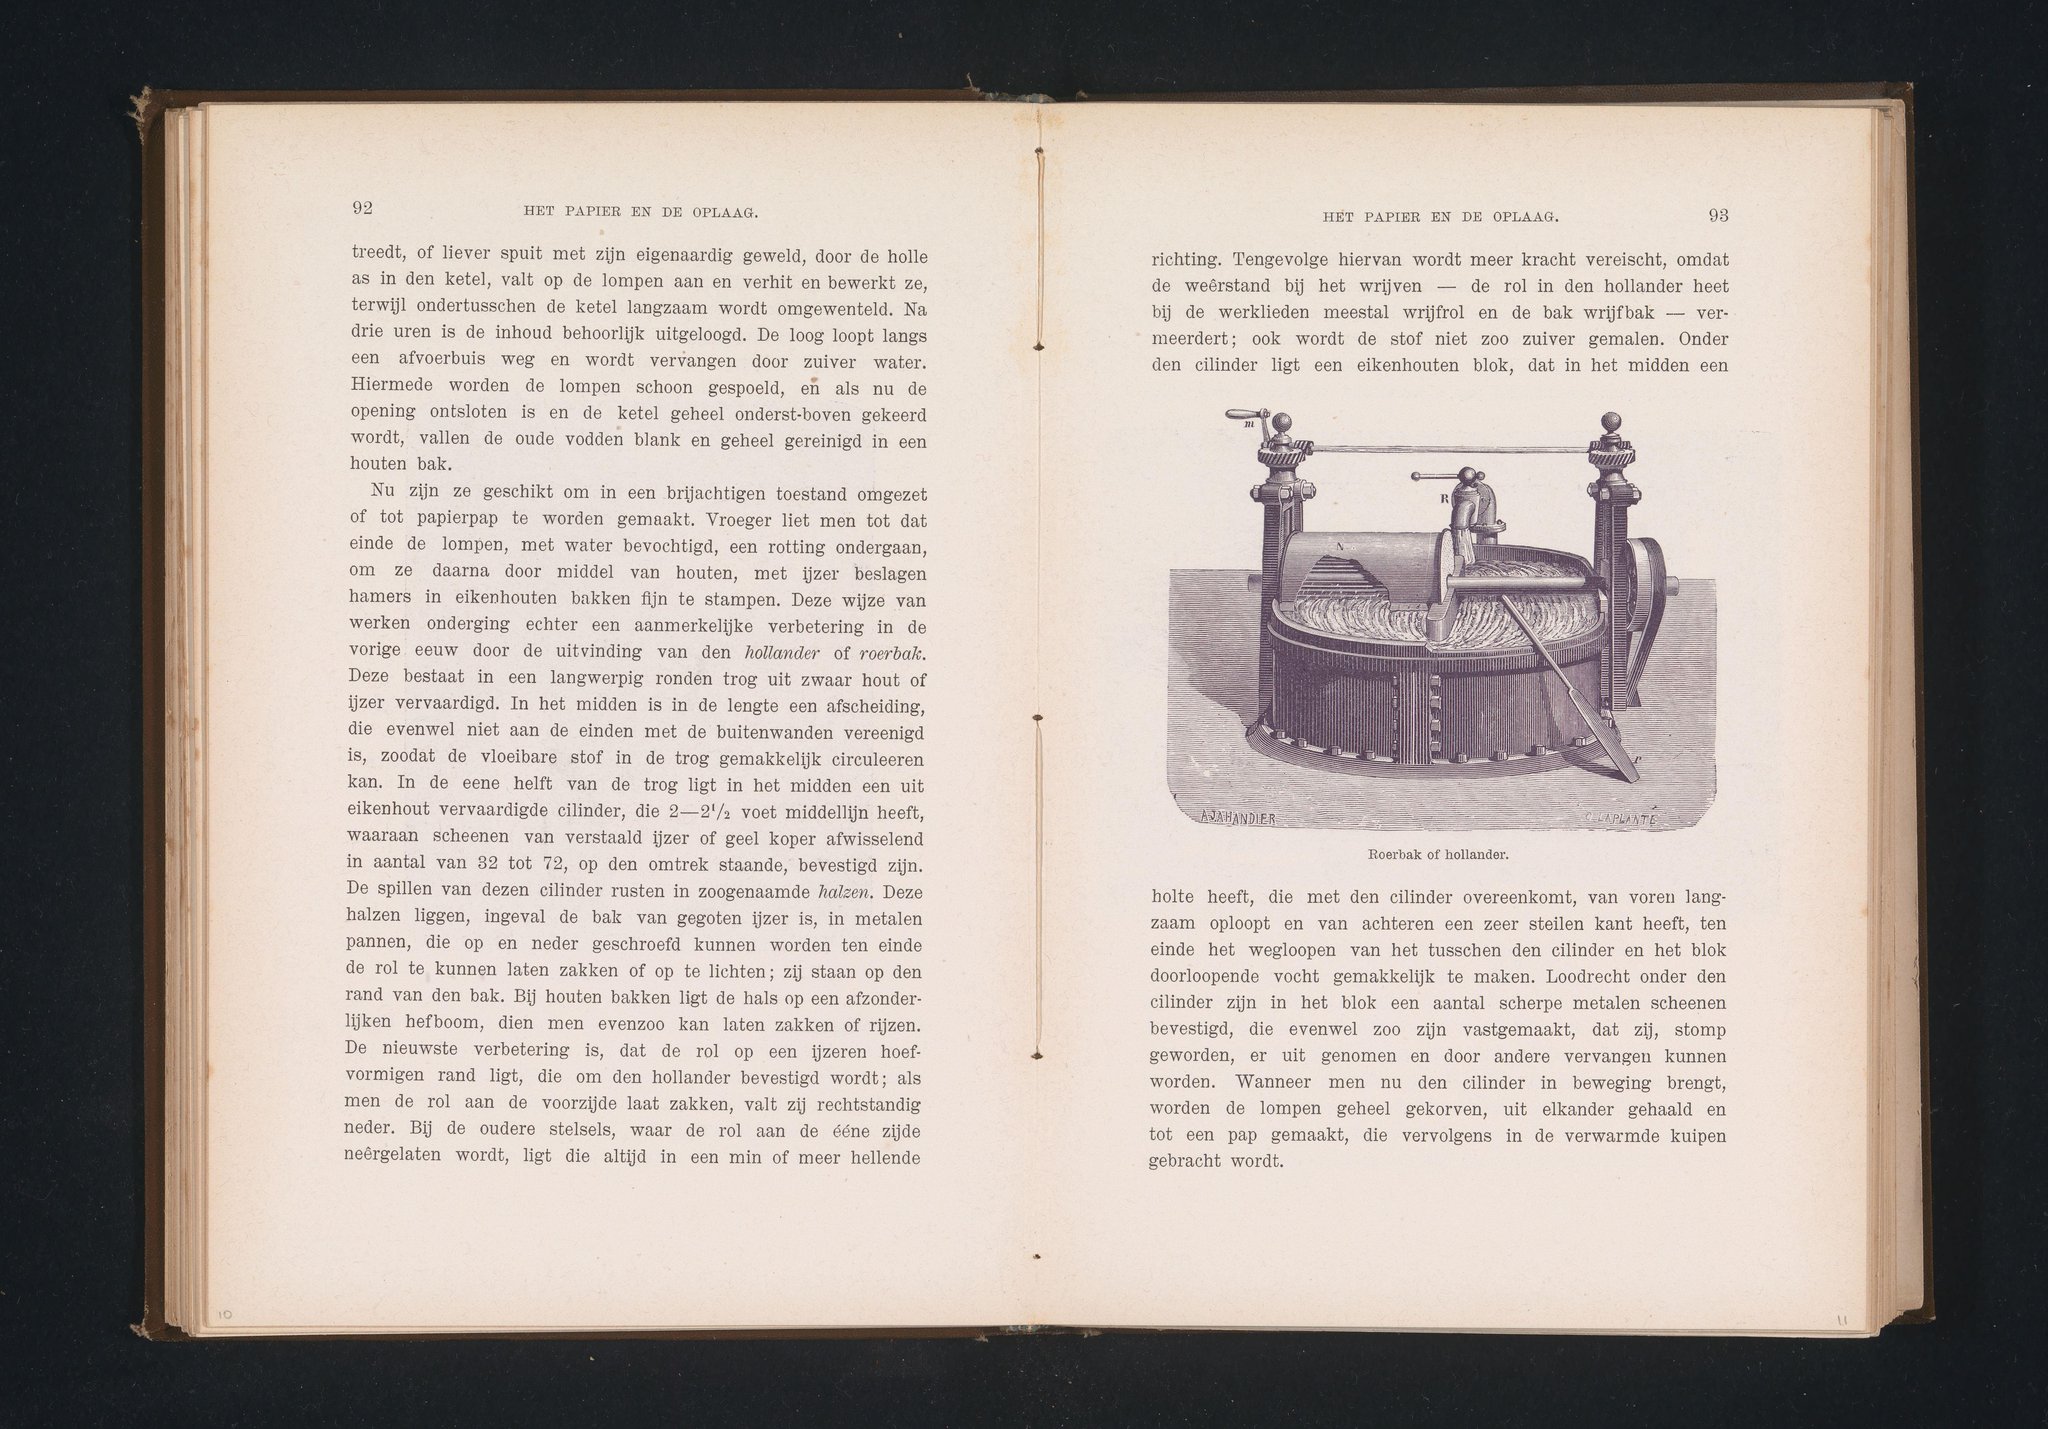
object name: photomechanical print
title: Roerbak of hollander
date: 1887-1892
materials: paper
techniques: printing block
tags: paper (writing material)